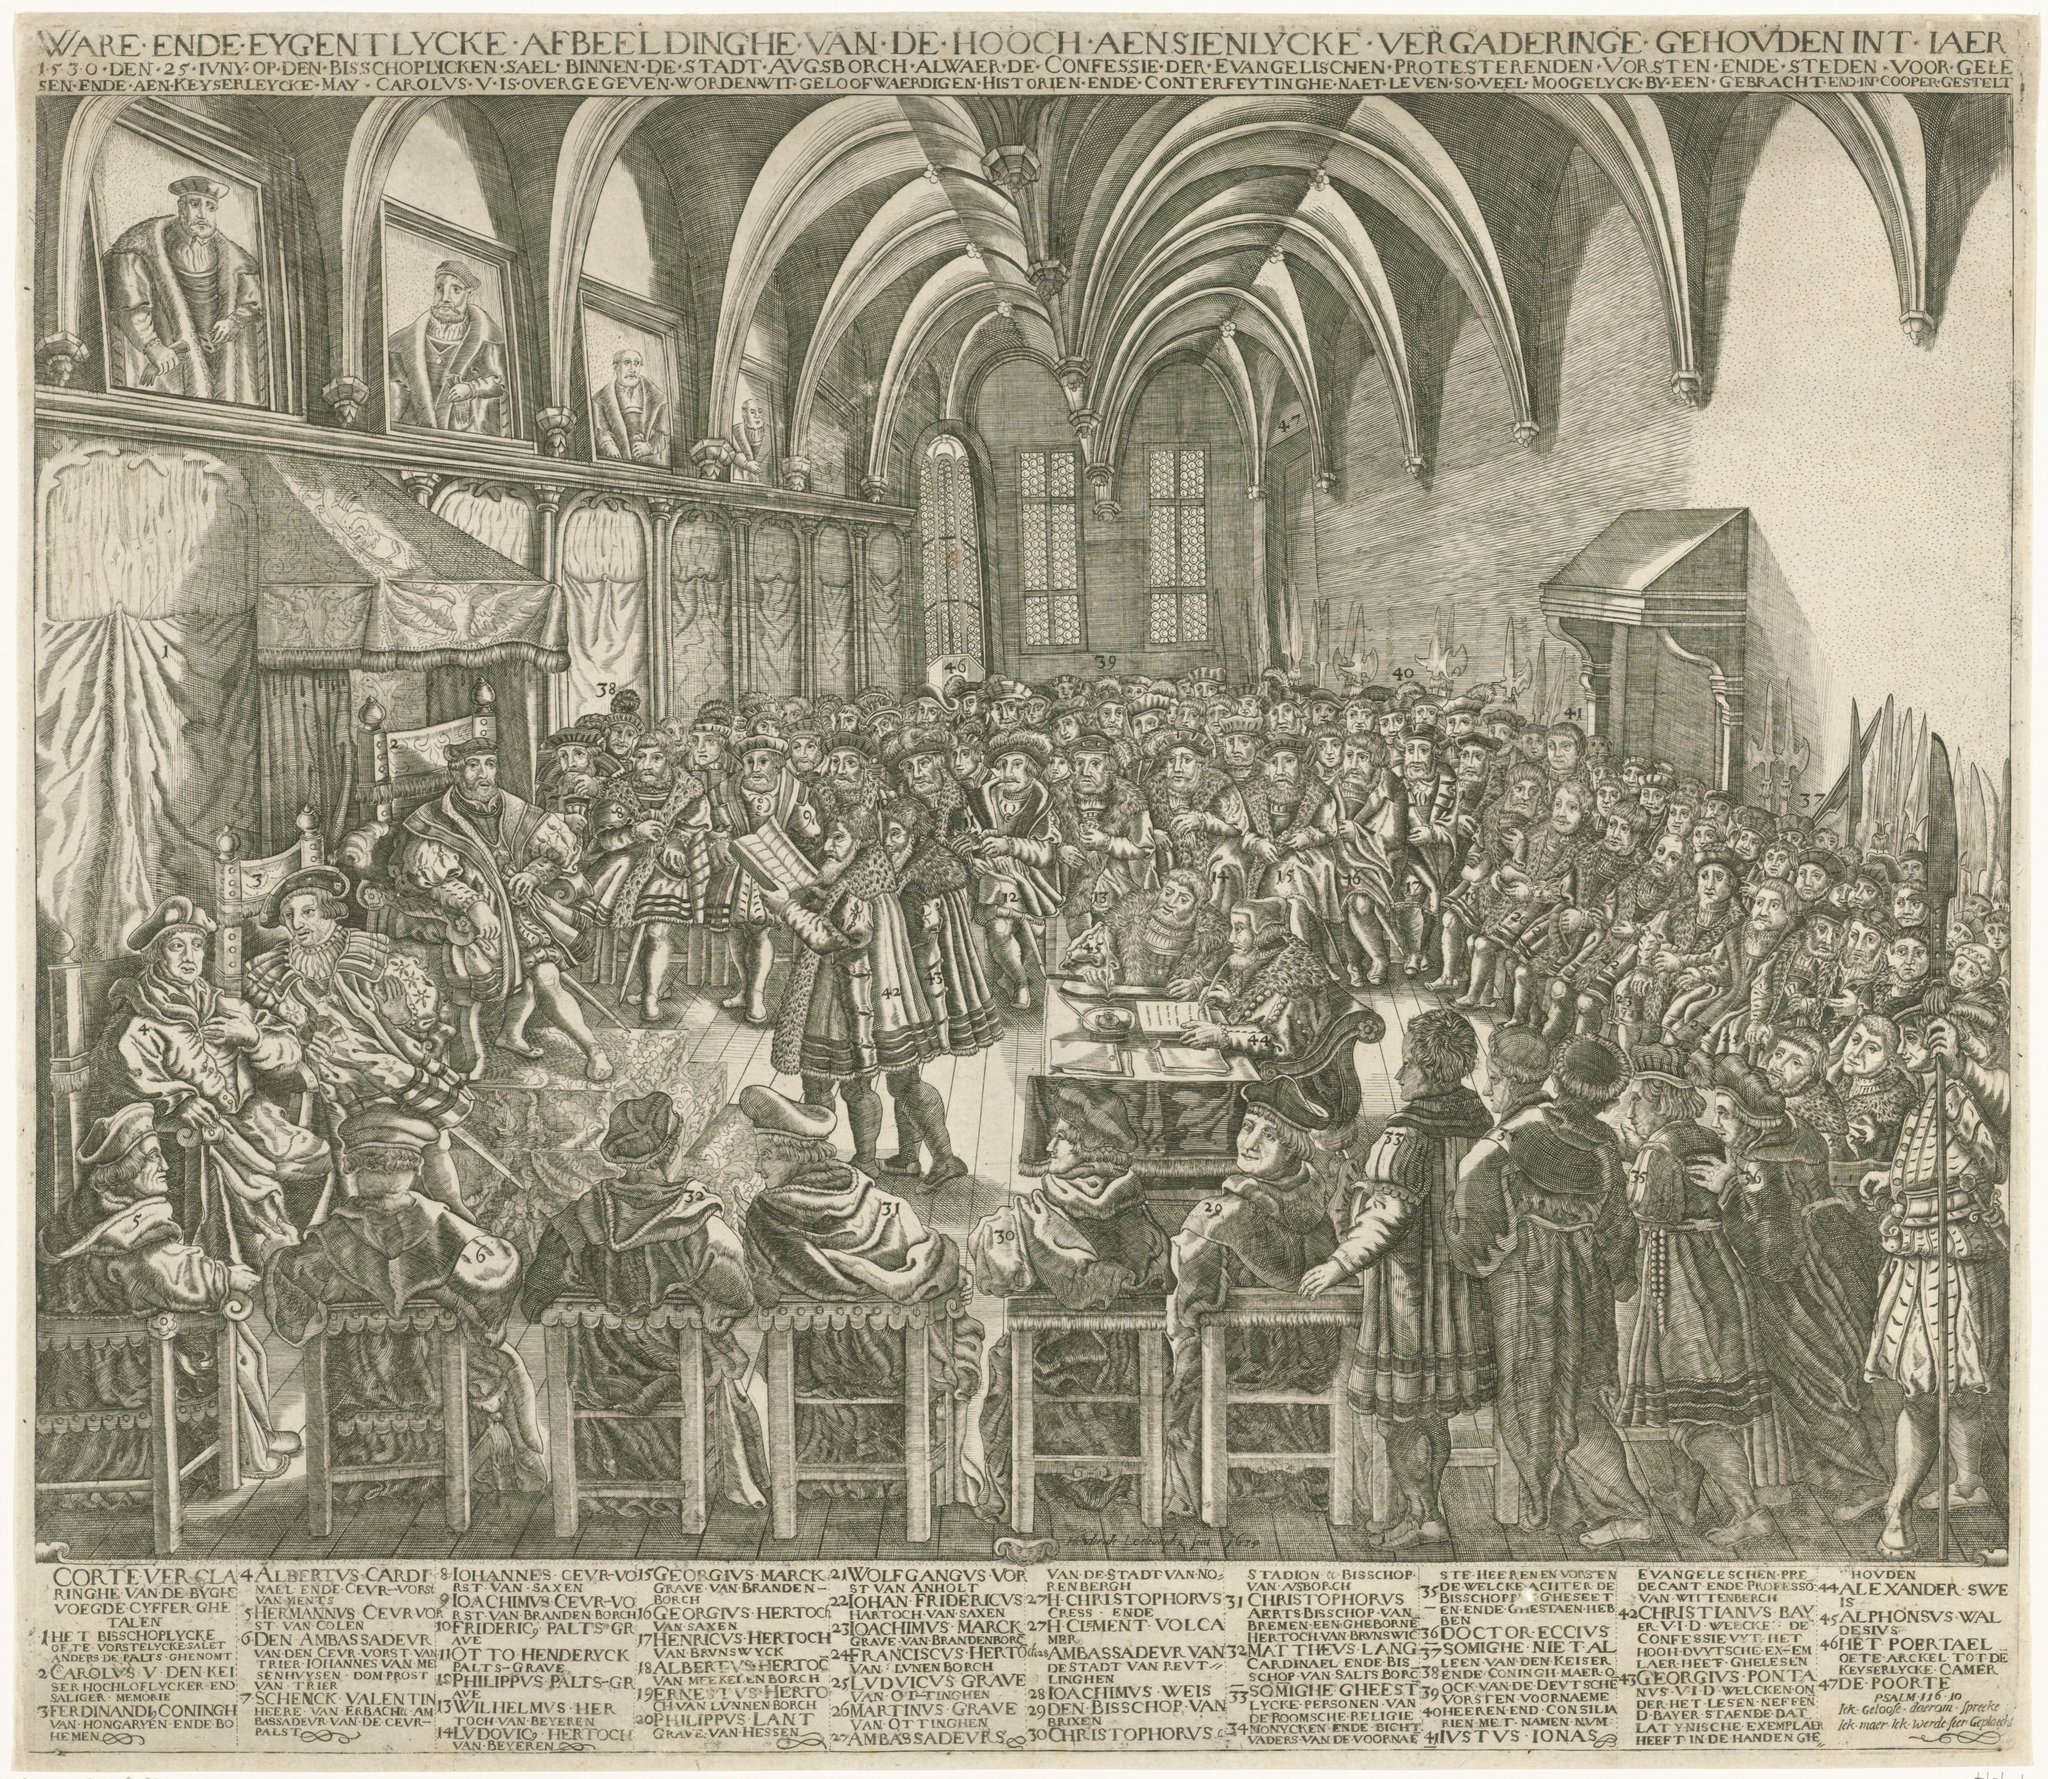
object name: print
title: Ware ende eygenlycke afbeeldinghe van de hooch aensienlycke vergaderinge gehouden int jaer 1530 den 25 juny op den bisschoplycken sael binnen de stadt Augsborch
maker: hendrick lodewyck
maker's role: print maker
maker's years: -1652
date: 1634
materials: paper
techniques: engraving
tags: ghent, charles v (holy roman emperor and king of spain), negotiations, conference ~ diplomacy, augsburg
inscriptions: collector's mark: Lugt 2228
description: Rijksdag van Augsburg, 25 juni 1530. Gezicht op de zaal met alle aanwezigen, links Karel V op zijn troon. Onder de voorstelling verklaring van de nummers 1-47 met de namen van de voorgestelden.